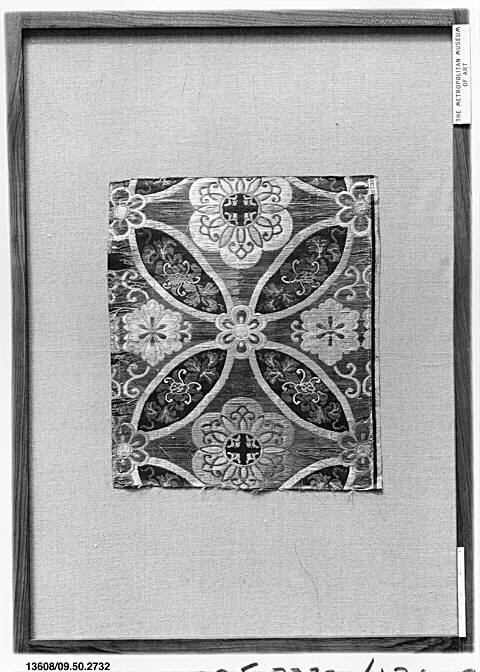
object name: piece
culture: japanese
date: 1615-1868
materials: metal thread, silk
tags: flowers